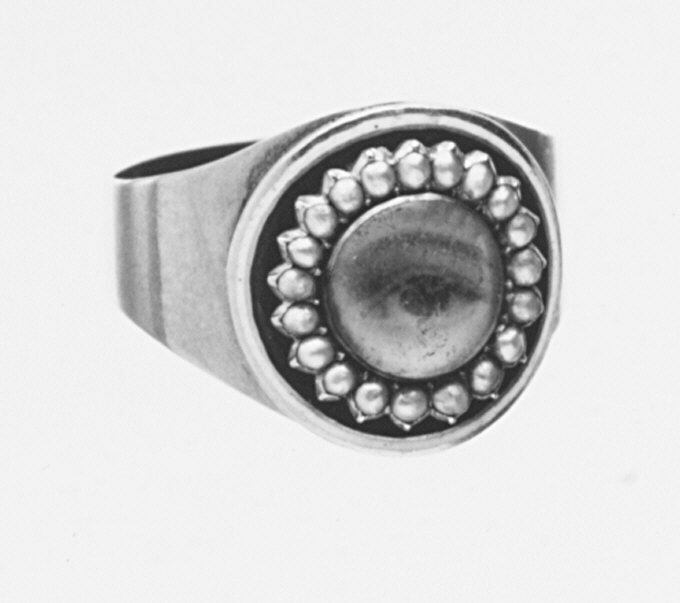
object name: painting, miniature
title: Eye Miniature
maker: british painter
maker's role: artist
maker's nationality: british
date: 1800-1829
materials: ivory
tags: eyes